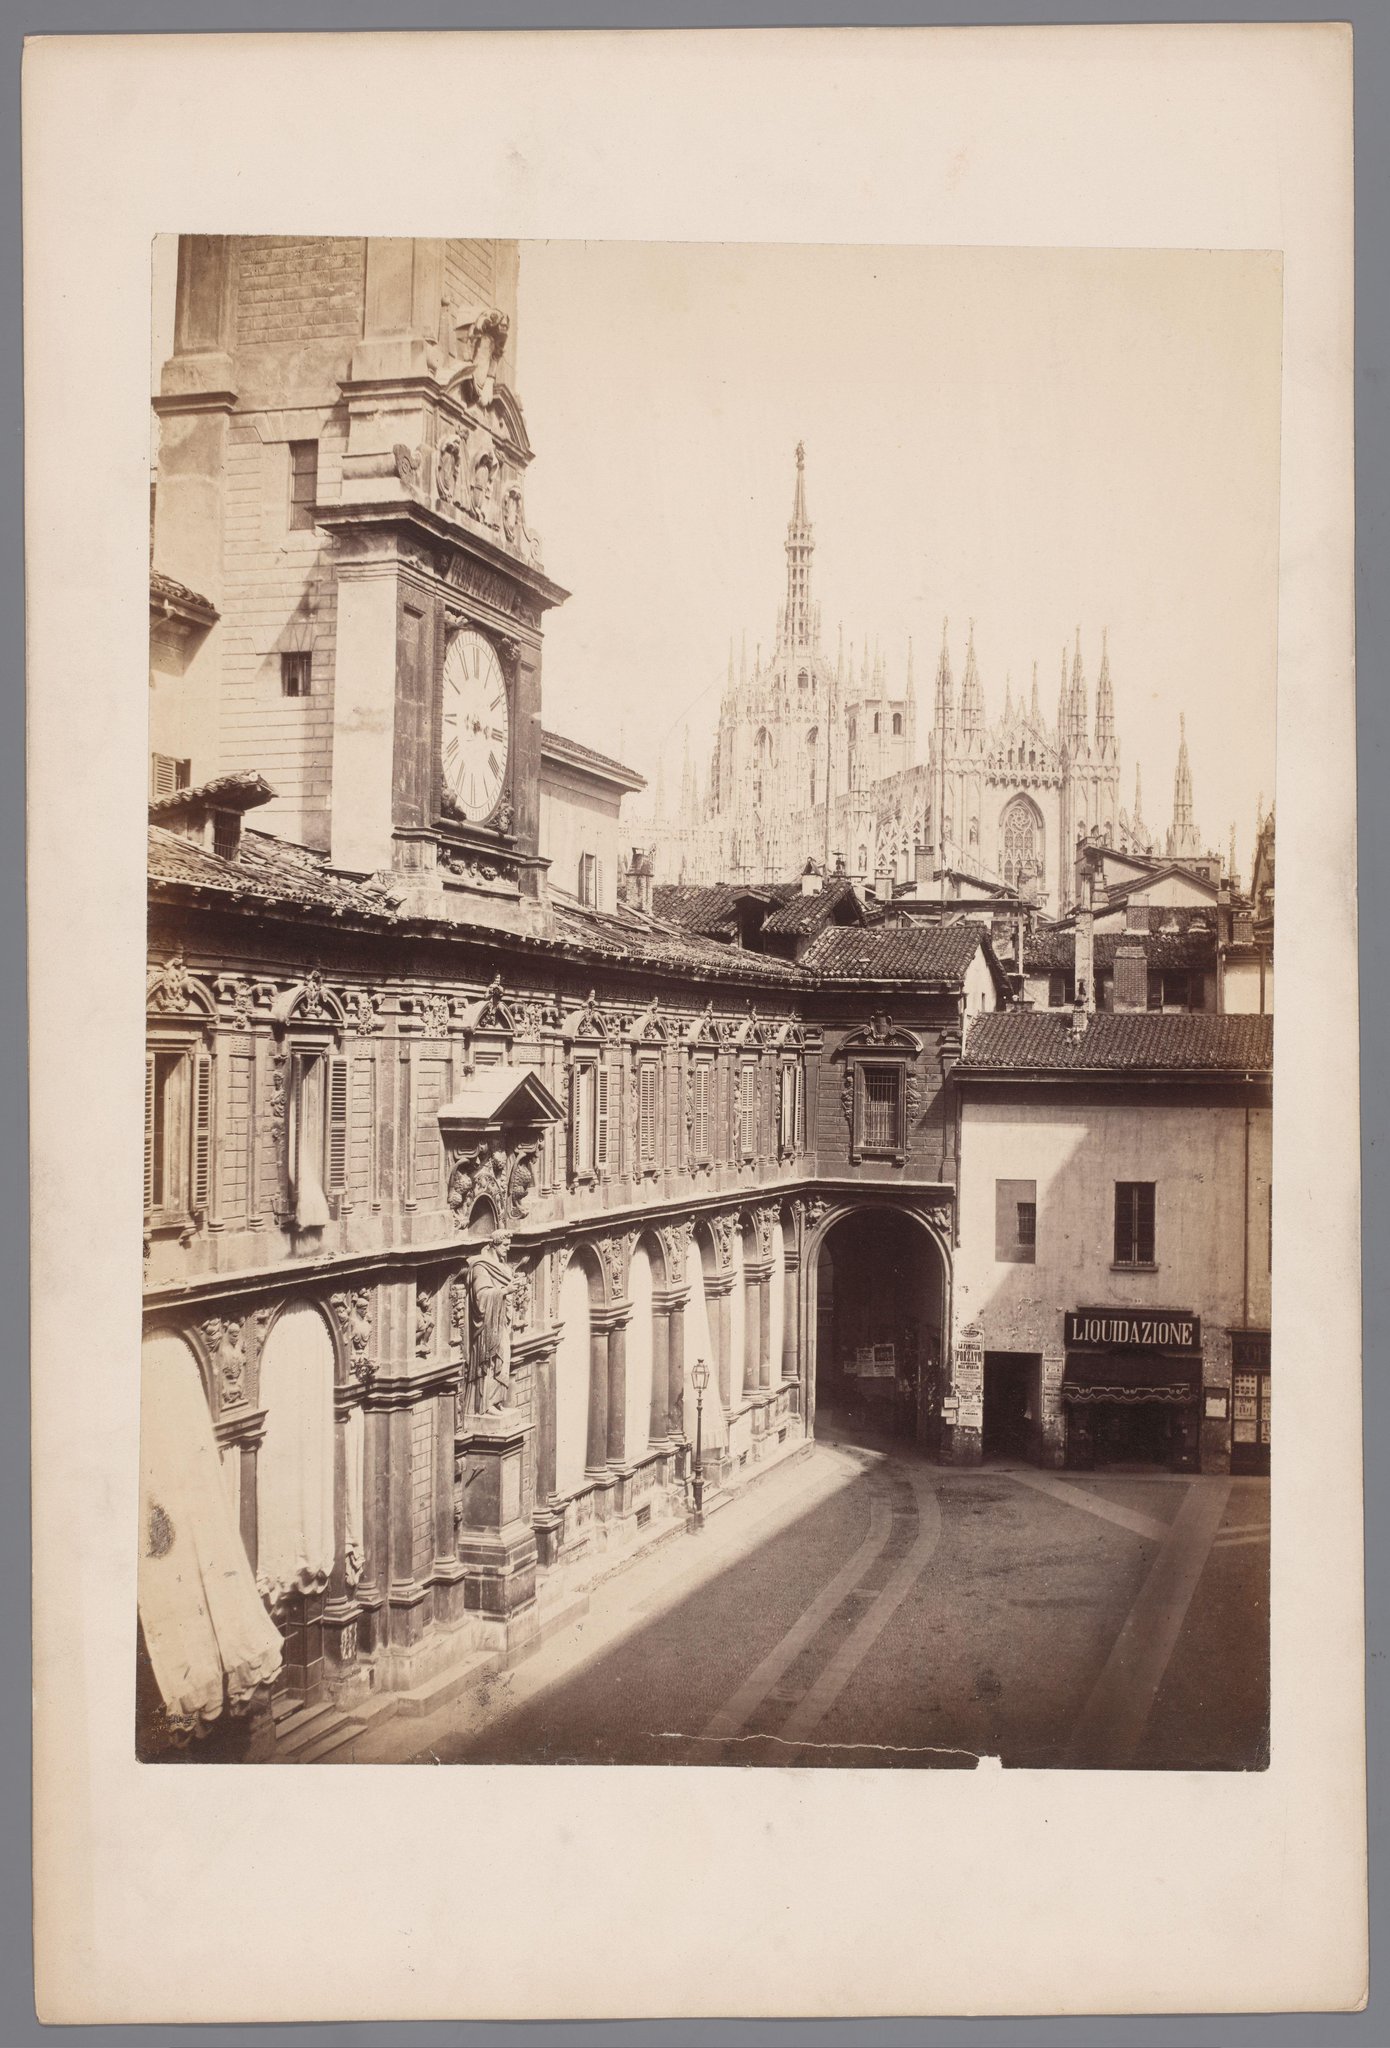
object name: photograph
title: Straat in Milaan met de kathedraal op de achtergrond, Italië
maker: pompeo pozzi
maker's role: fotograaf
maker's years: 1817-1880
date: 1851-1880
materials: cardboard, paper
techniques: albumen print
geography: milan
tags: church (exterior), street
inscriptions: inscription: ‘pl 10’, inscription: ‘Pozzi’, collector's mark: ‘RIJKS SCHOOL VOOR KUNSTNIJVERHEID/ GROEP’